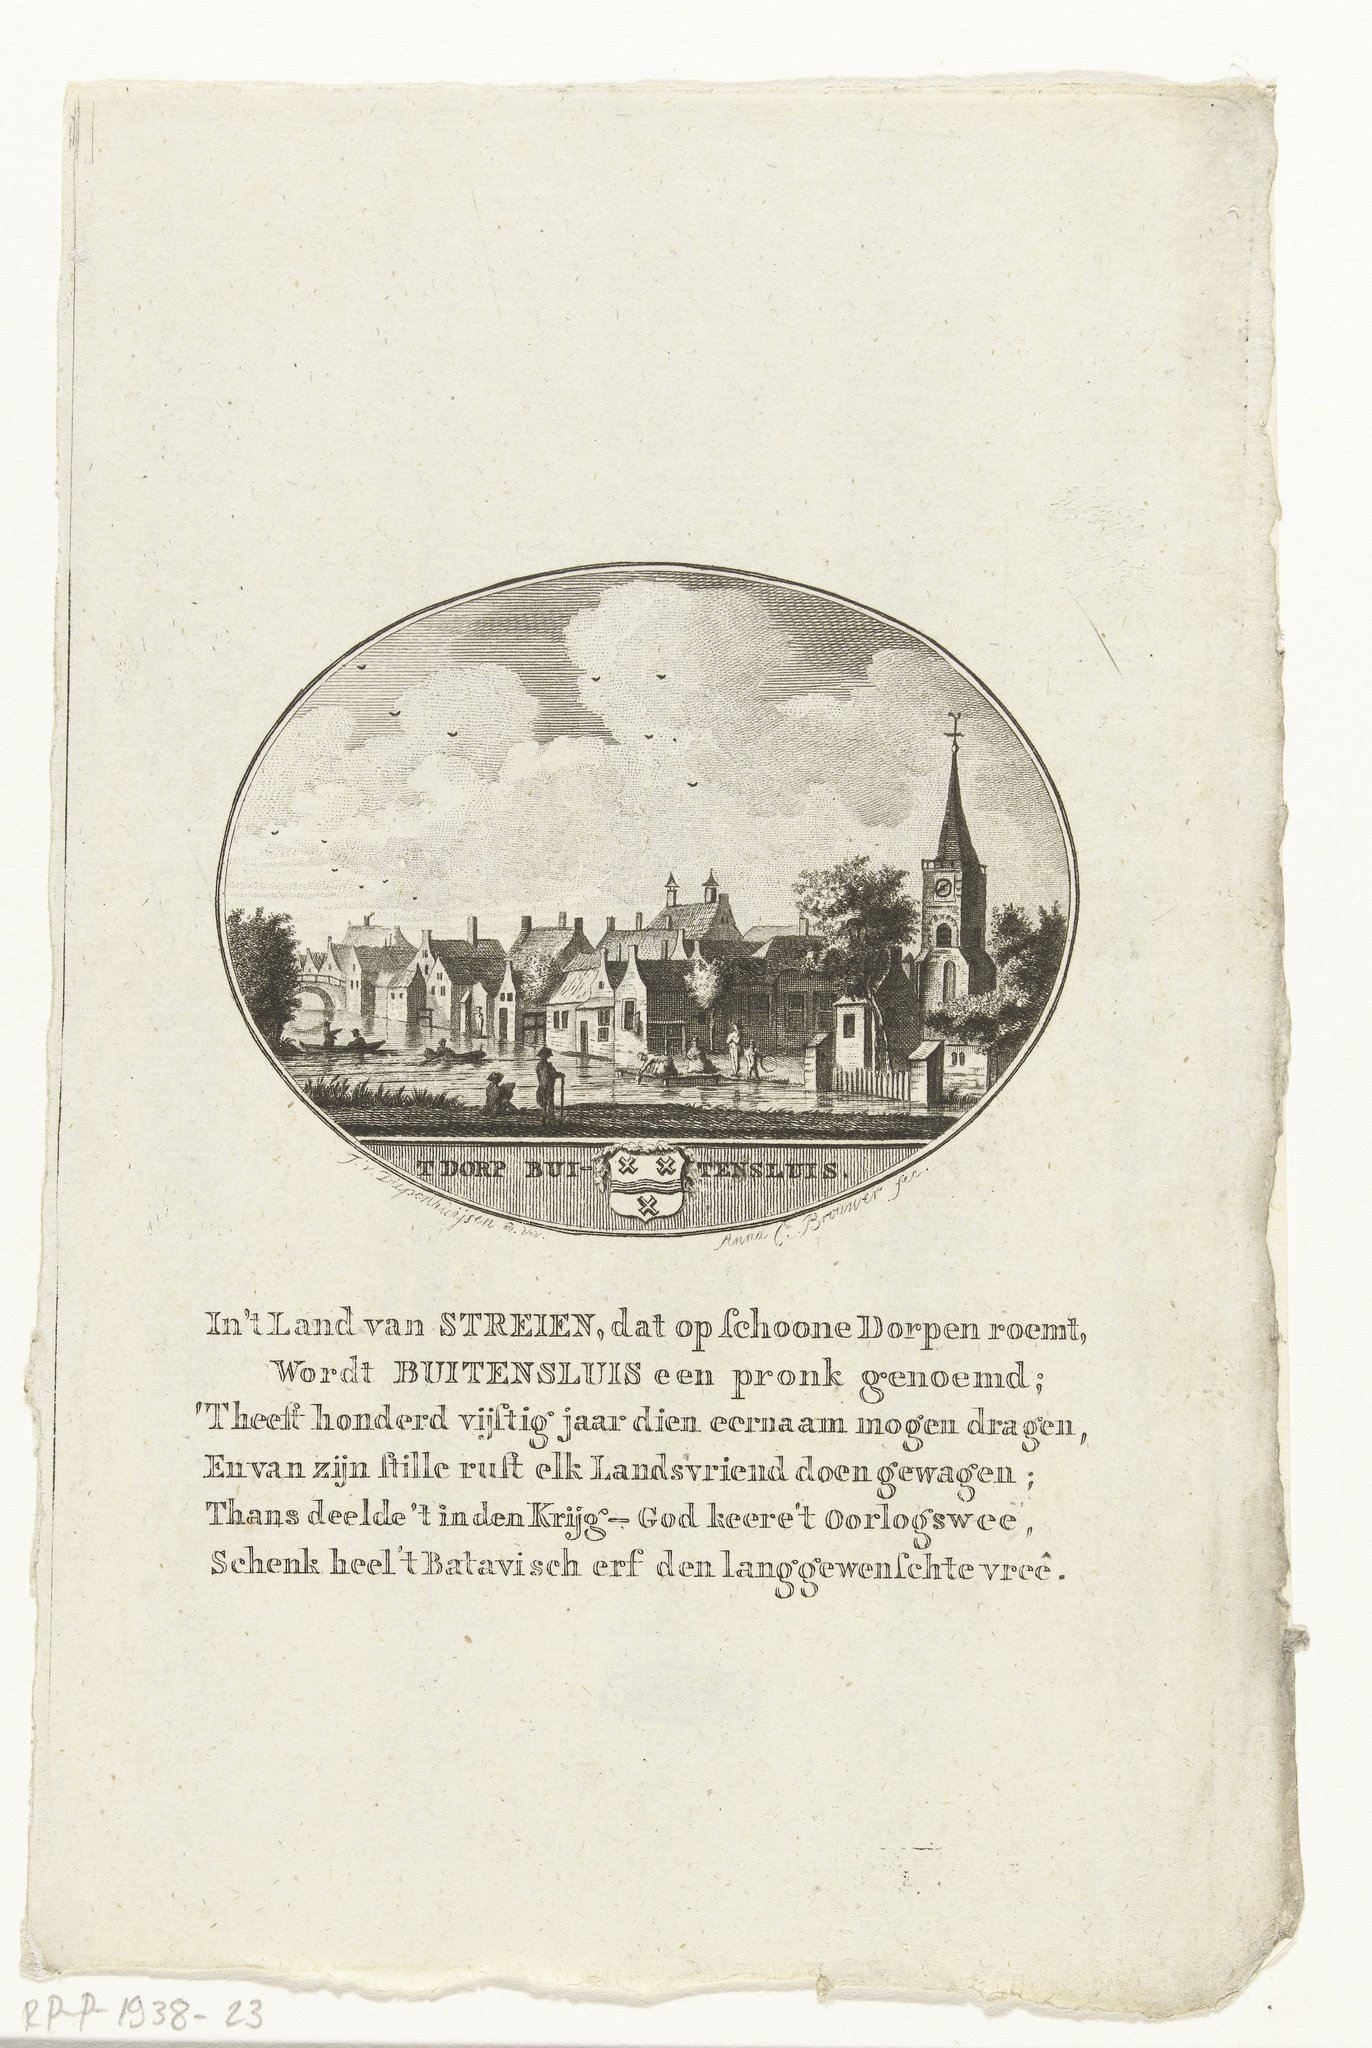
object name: print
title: 't Dorp Buitensluis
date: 1791-1793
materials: paper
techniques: etching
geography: amsterdam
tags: city-view in general; 'veduta'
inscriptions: collector's mark: Lugt 2228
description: afkomstig uit: L. van Ollefen, De Nederlandsche stad- en dorp-beschrijver. Deel 1, Amsterdam: Hendrik Arend Banse, 1793.